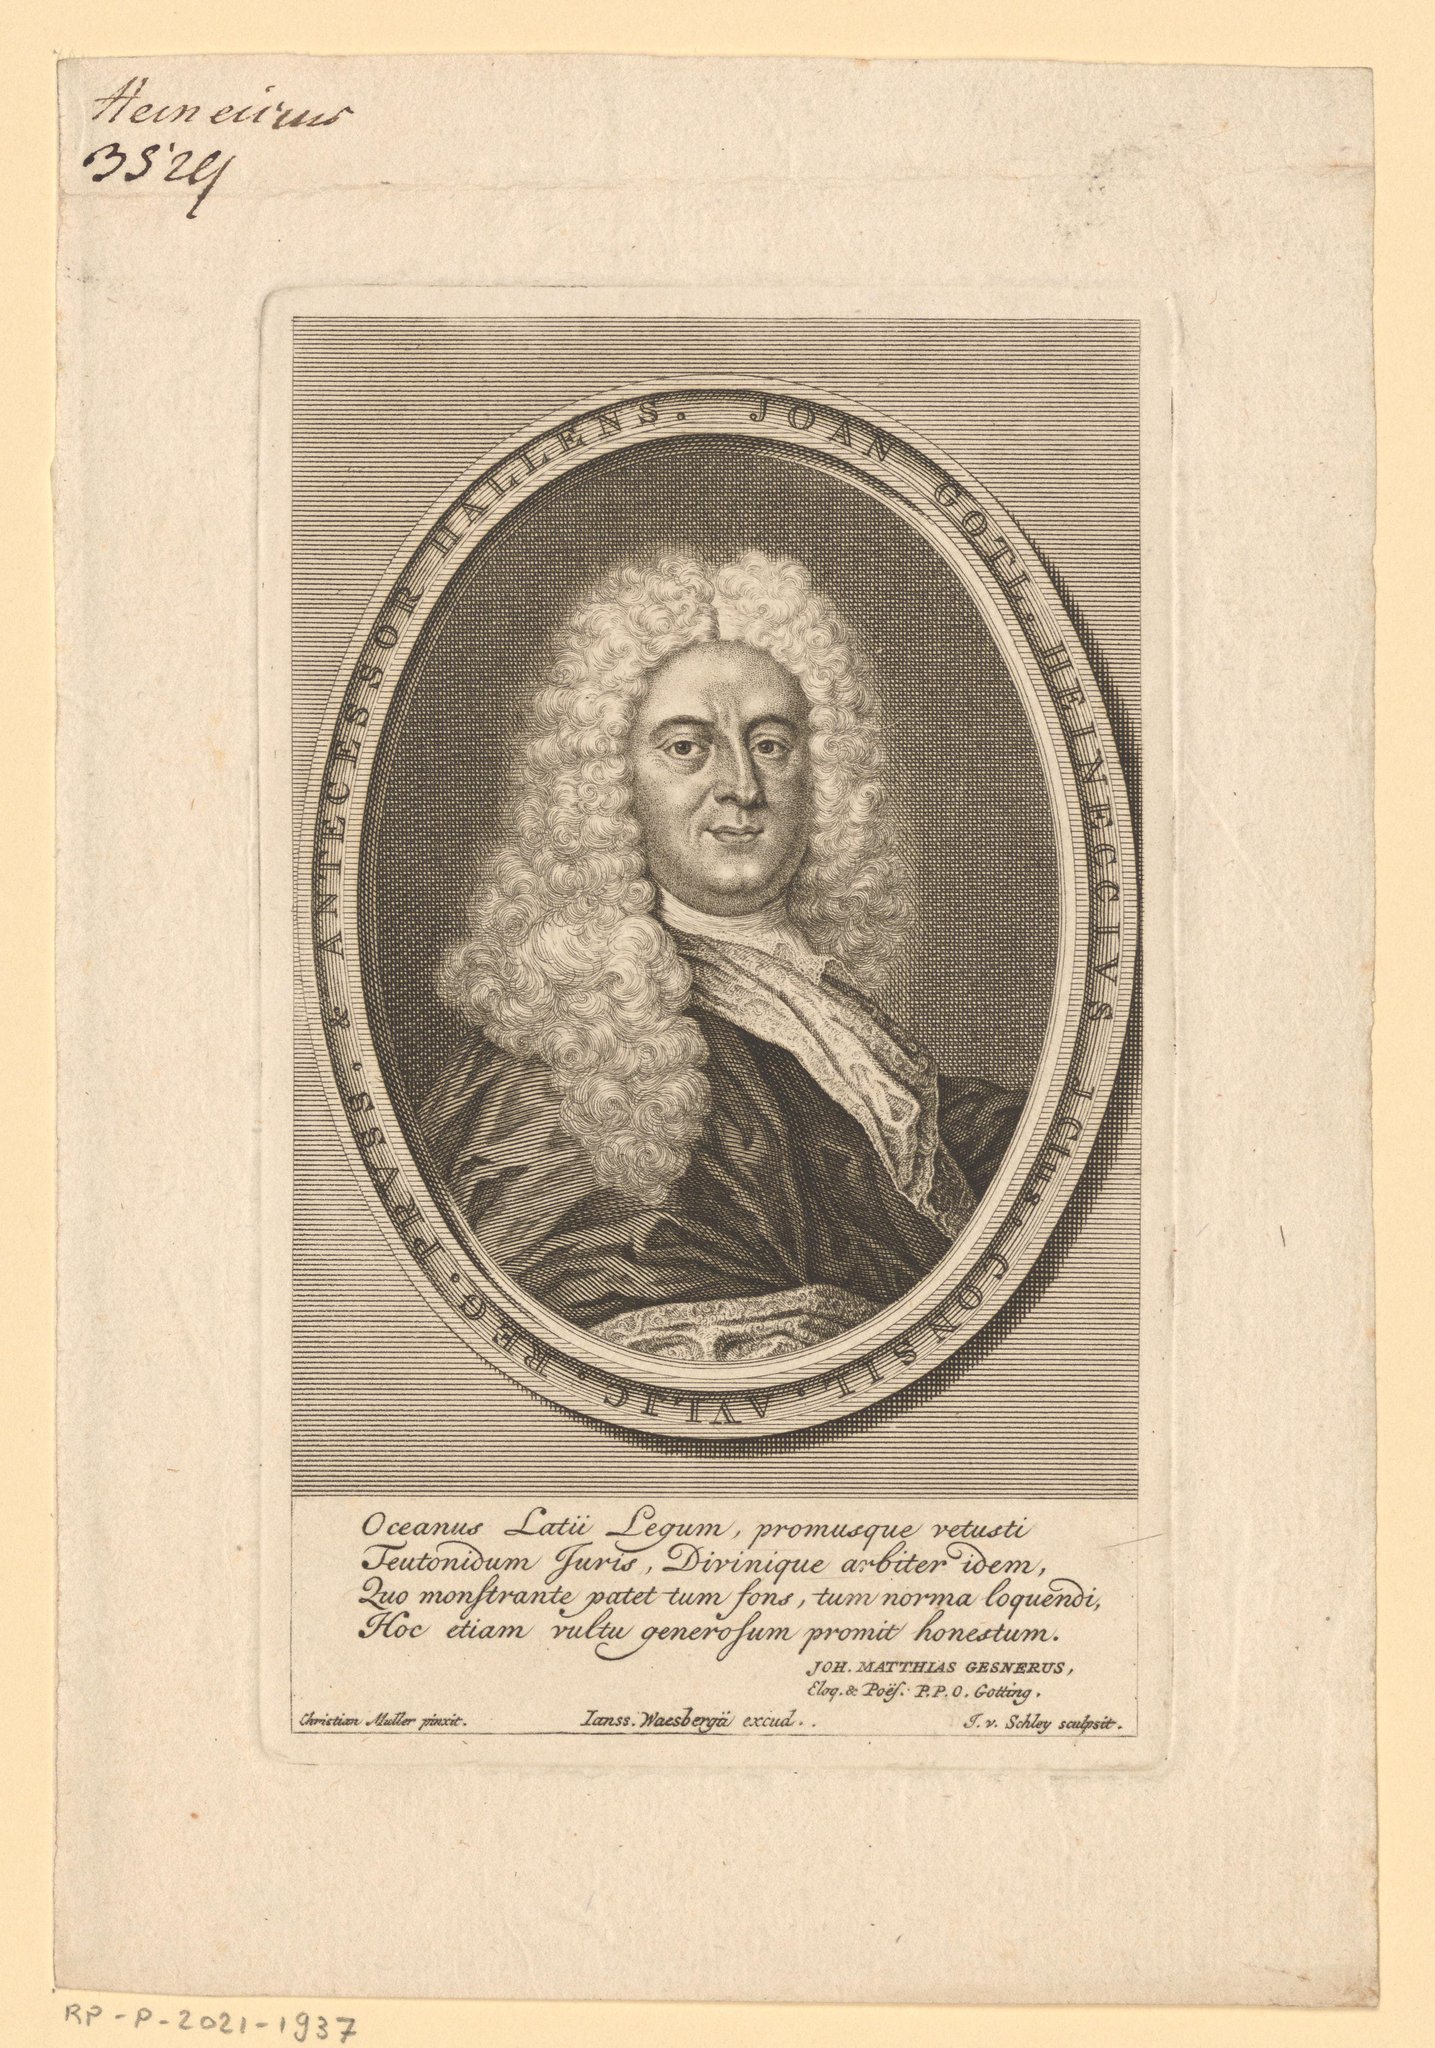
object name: print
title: Portret van Johann Gottlieb Heinecke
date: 1725-1779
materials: paper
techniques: engraving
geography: amsterdam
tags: scholar, philosopher, historical persons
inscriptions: inscription: ‘Heineccius/ [...]’